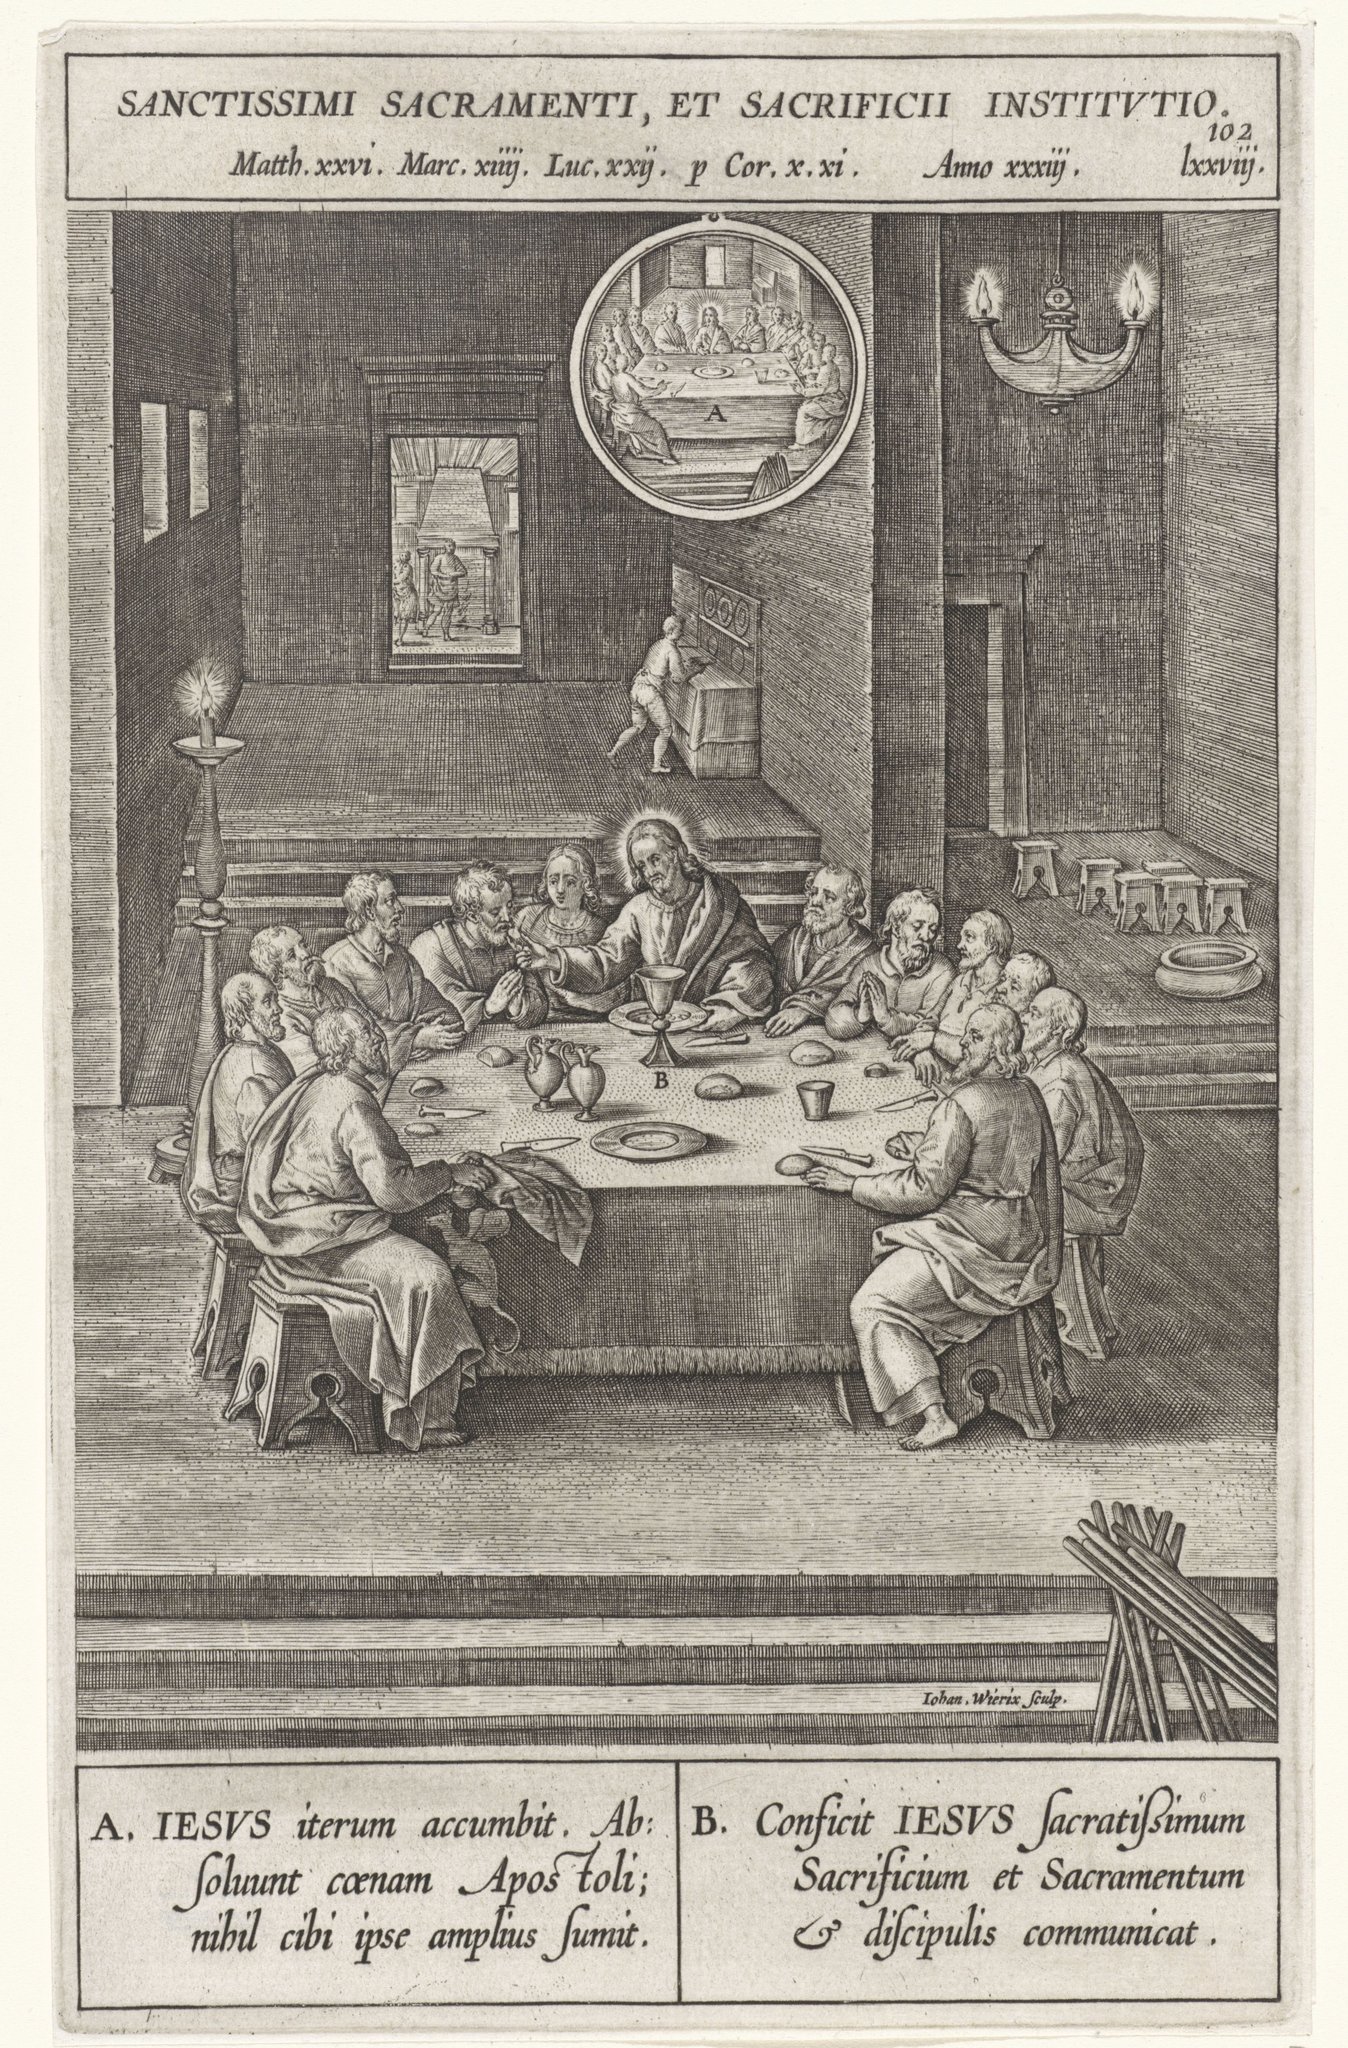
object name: print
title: Laatste Avondmaal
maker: johannes wierix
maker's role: draughtsman, print maker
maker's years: 1549-1618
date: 1593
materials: paper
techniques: engraving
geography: antwerp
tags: communion of the apostles: christ giving bread (host) and/or wine to the (standing) apostles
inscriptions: collector's mark: Lugt 2165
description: Christus zit met zijn leerlingen rond een tafel tijdens het laatste avondmaal. Hij zegent het brood en laat zijn leerlingen ervan eten. Bij verschillende elementen uit de voorstelling staan letters die corresponderen met de legenda in de marge.